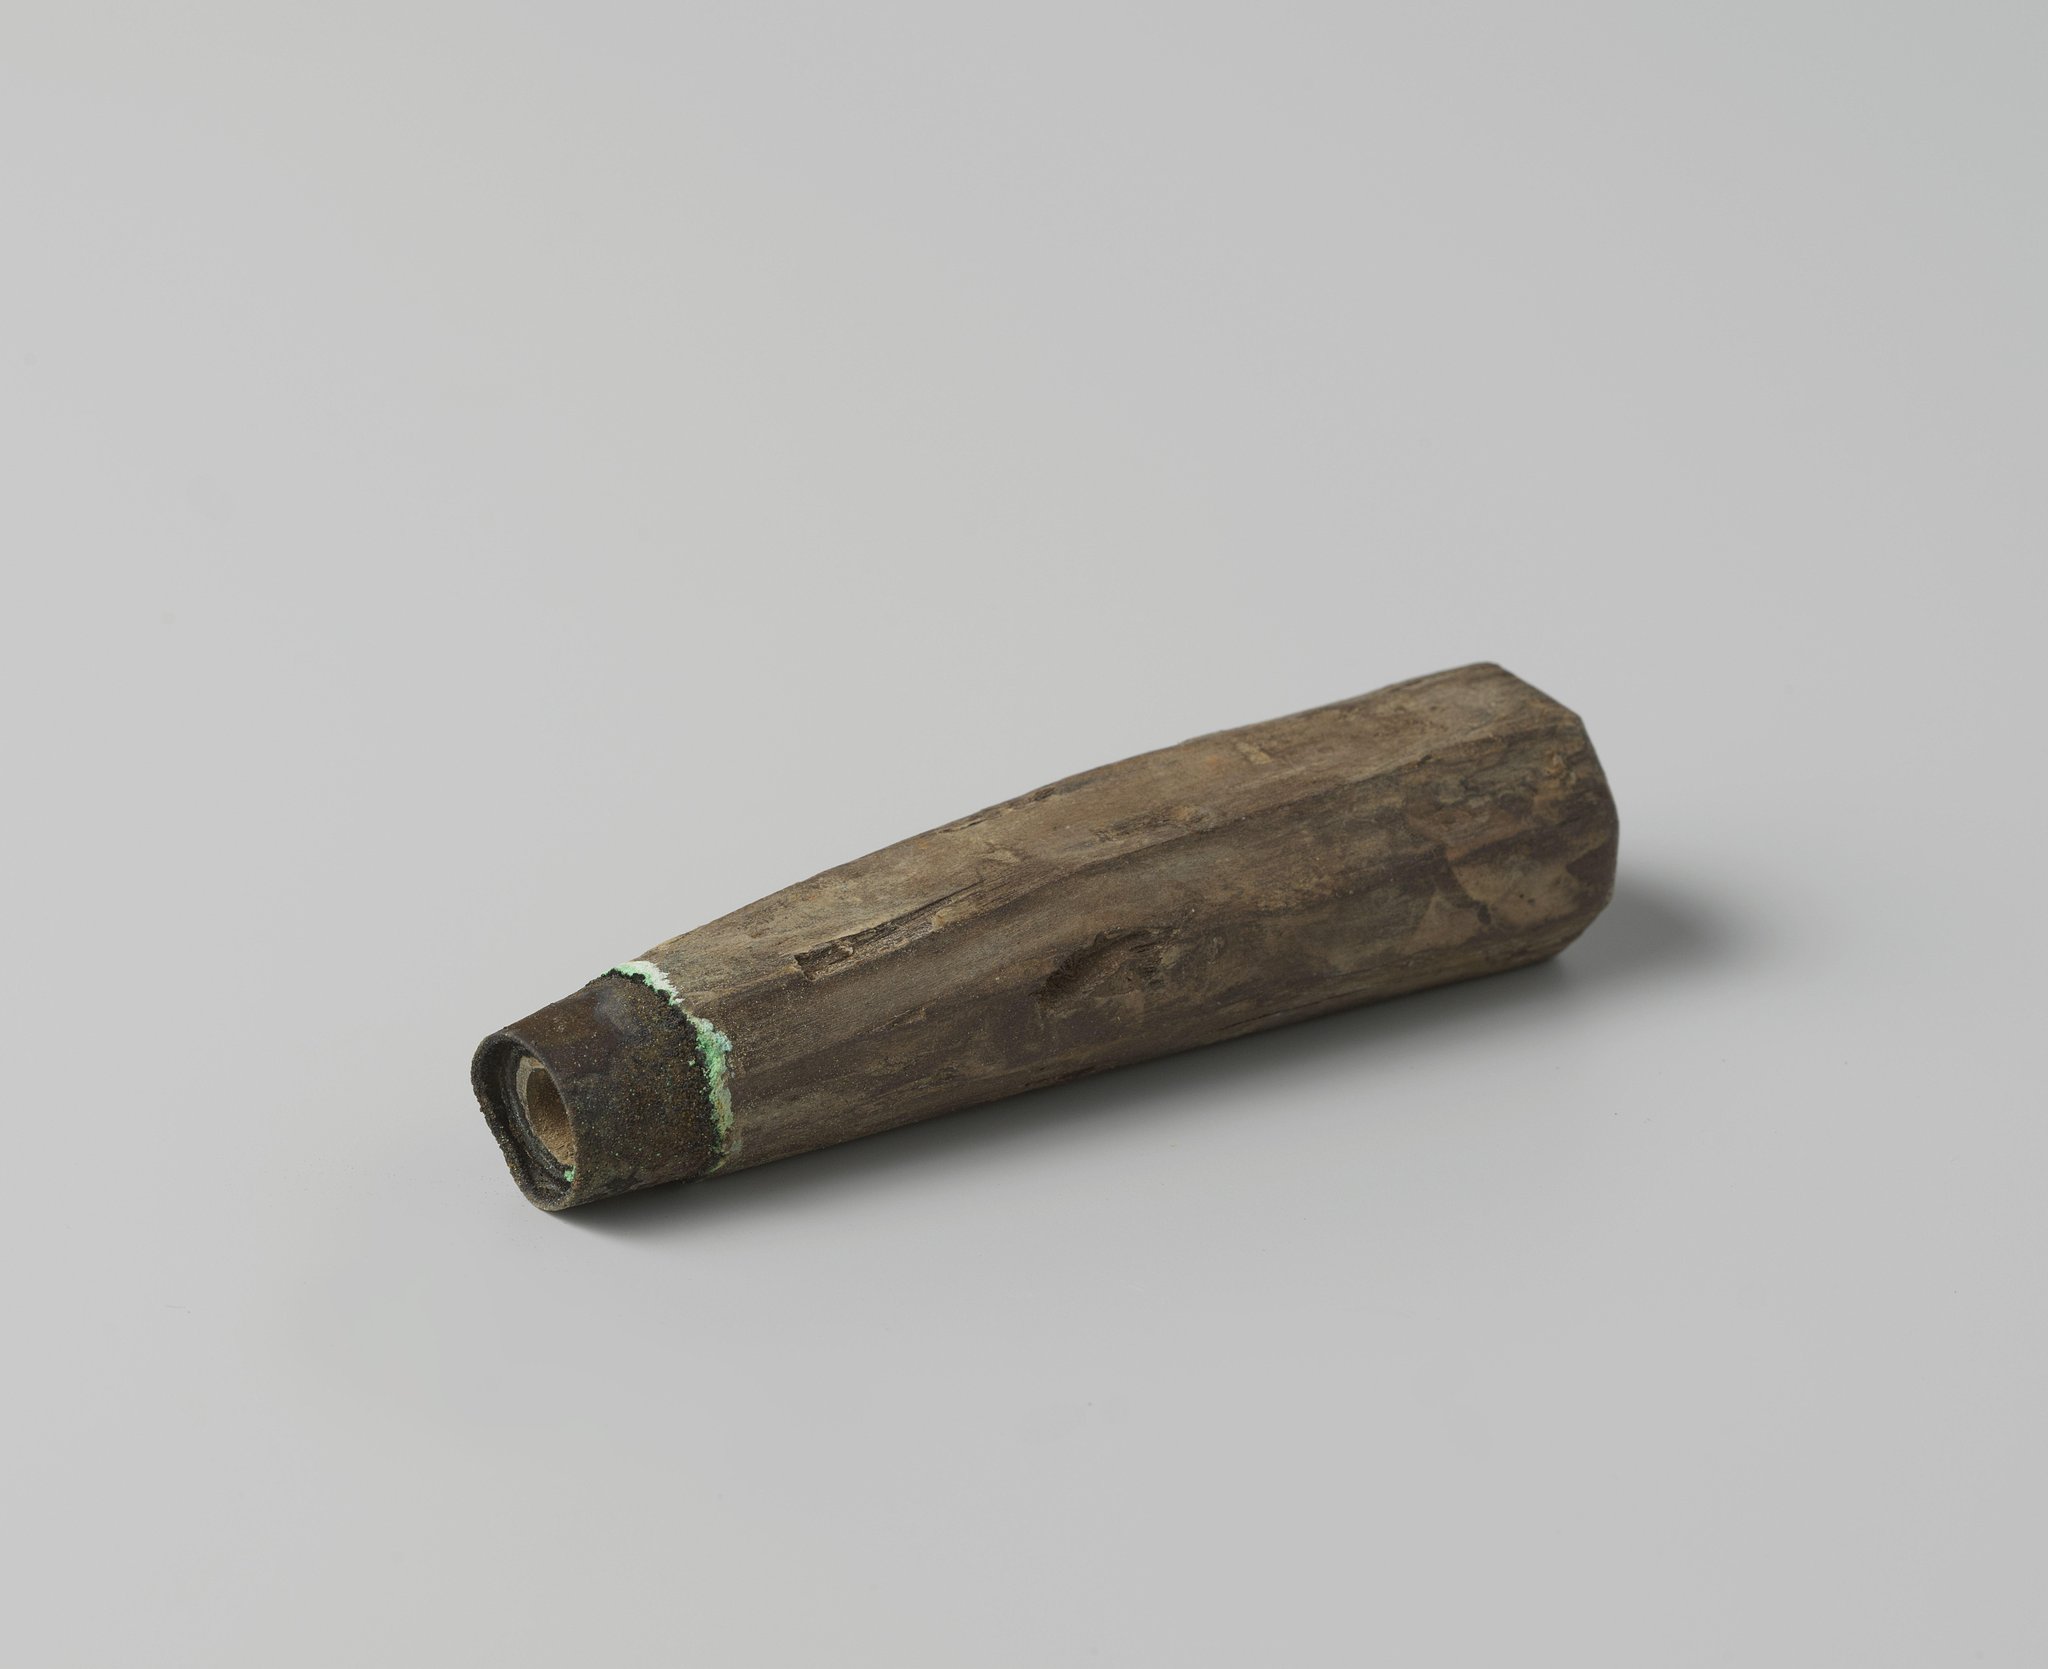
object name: knife handle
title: Messenheft uit het wrak van de in 1735 vergane Oost-Indiëvaarder 't Vliegend Hart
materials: copper, wood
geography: netherlands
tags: 't vliegend hart (schip), verenigde oostindische compagnie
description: Taps toelopend houten messenheft, achterkant plat, 6-kantig gesneden, aan de snede-kant uitgehold en voorzien van een koperen ring. Knife-handle.